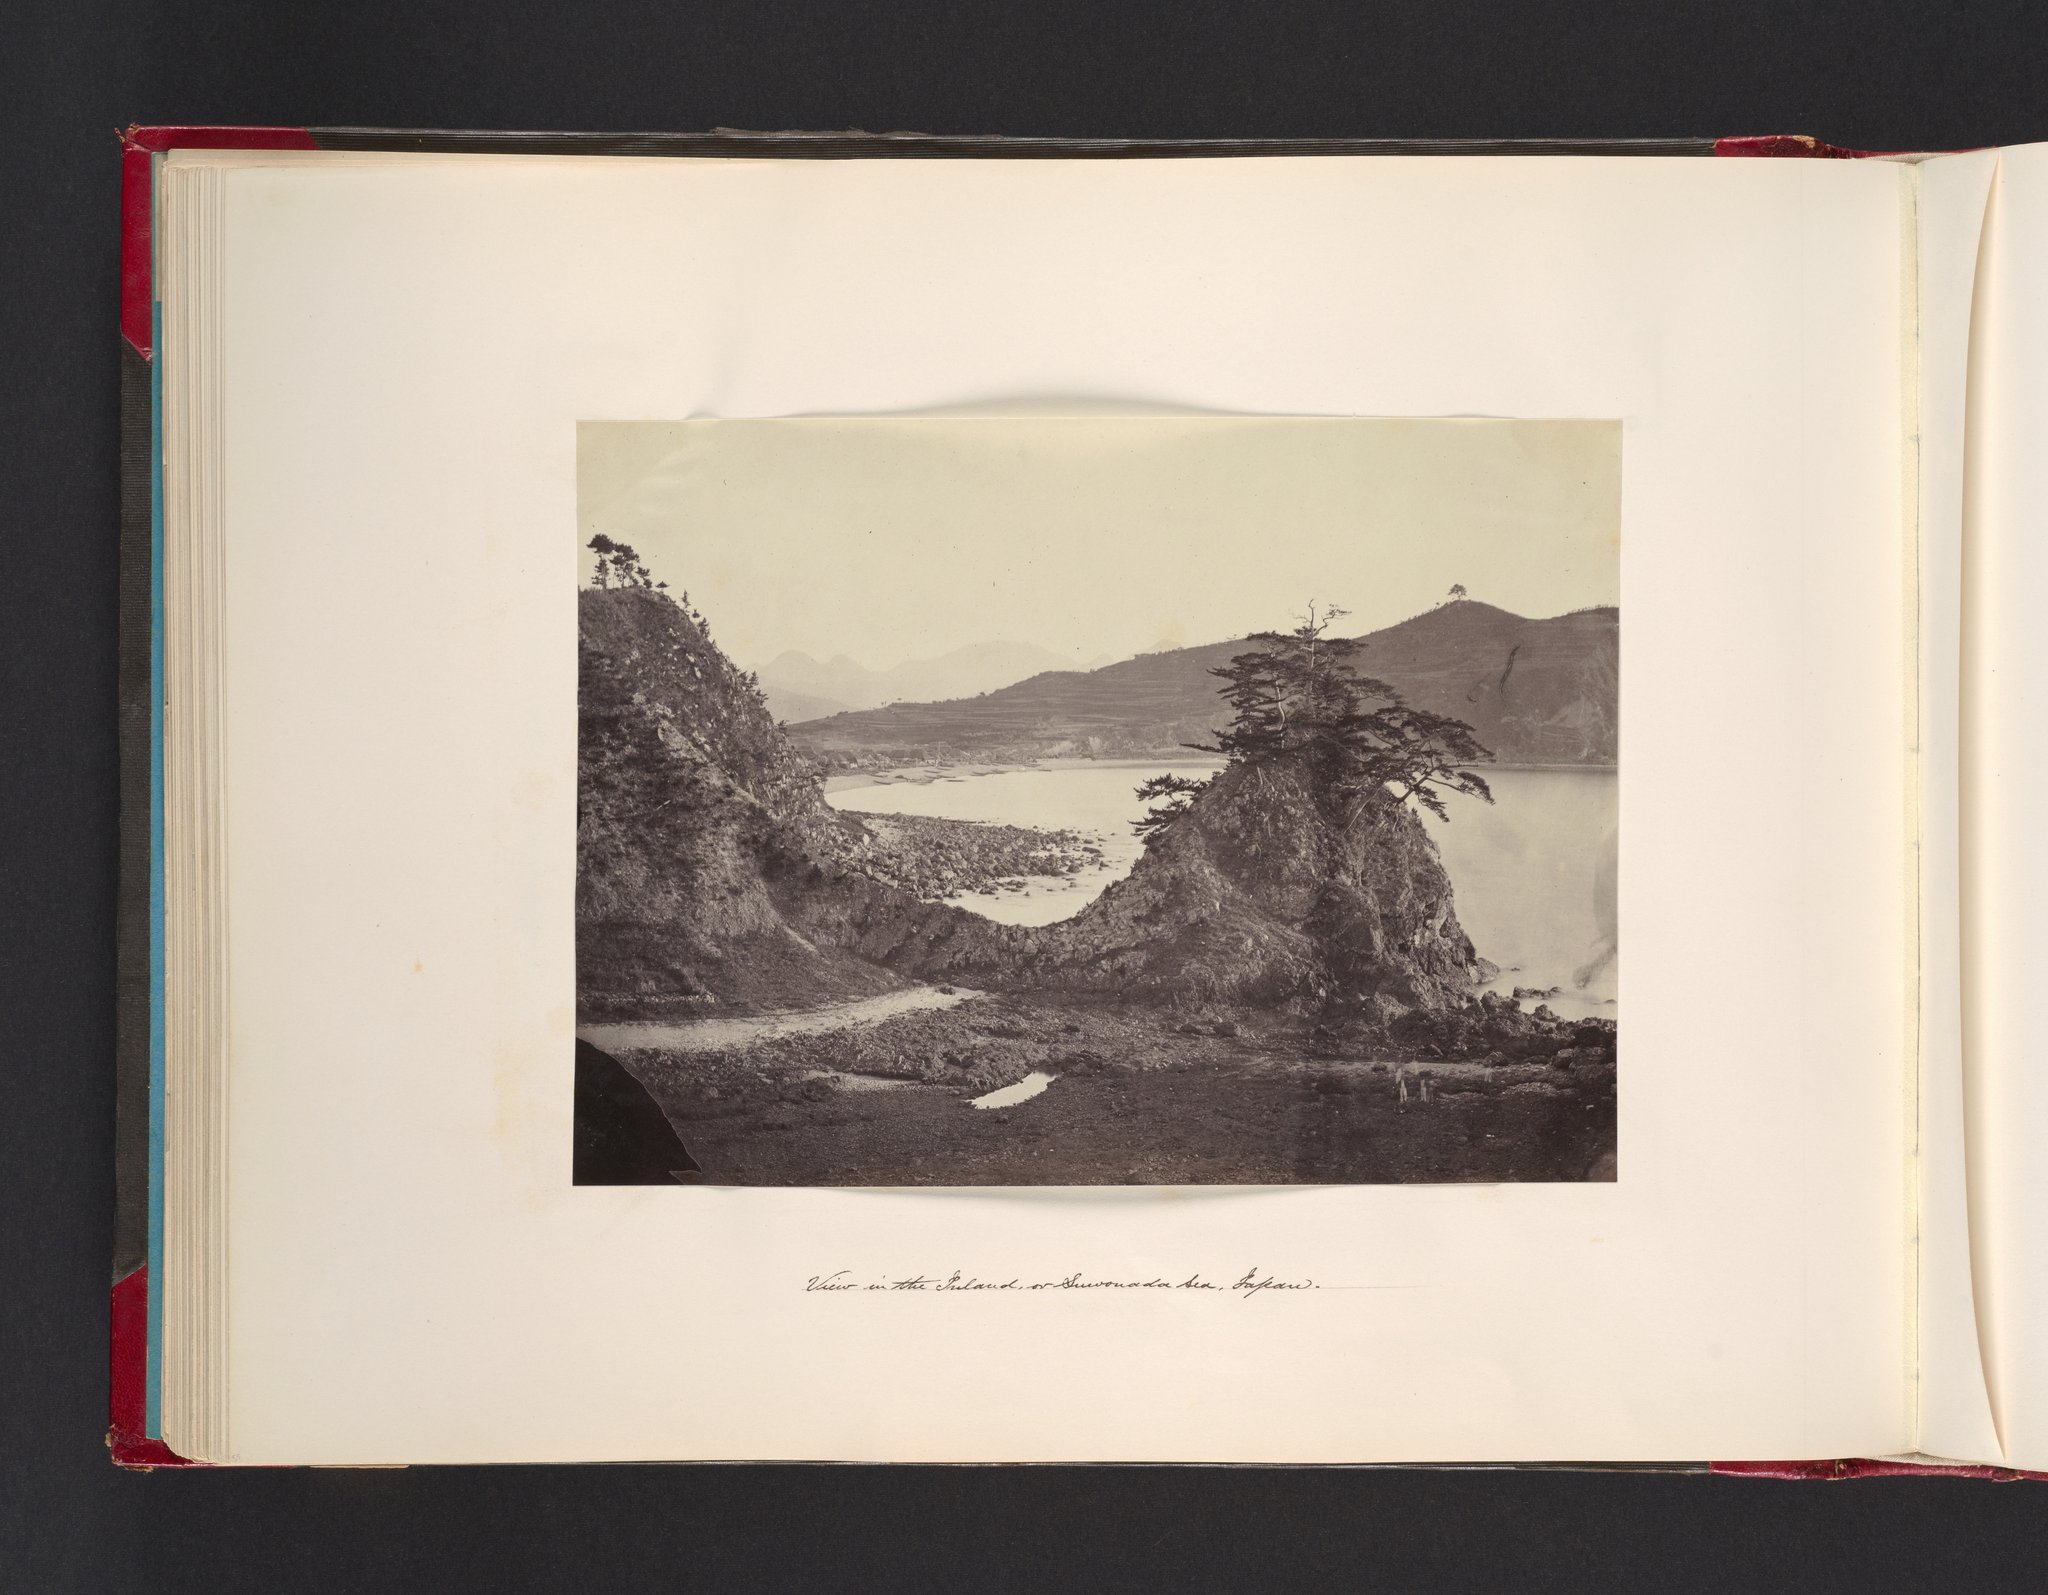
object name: photograph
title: View in the Island [?], or Suwada Sea, Japan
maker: john thomson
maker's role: artist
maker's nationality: british, scottish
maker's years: 1837-1921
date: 1865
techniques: albumen silver print, glass negative